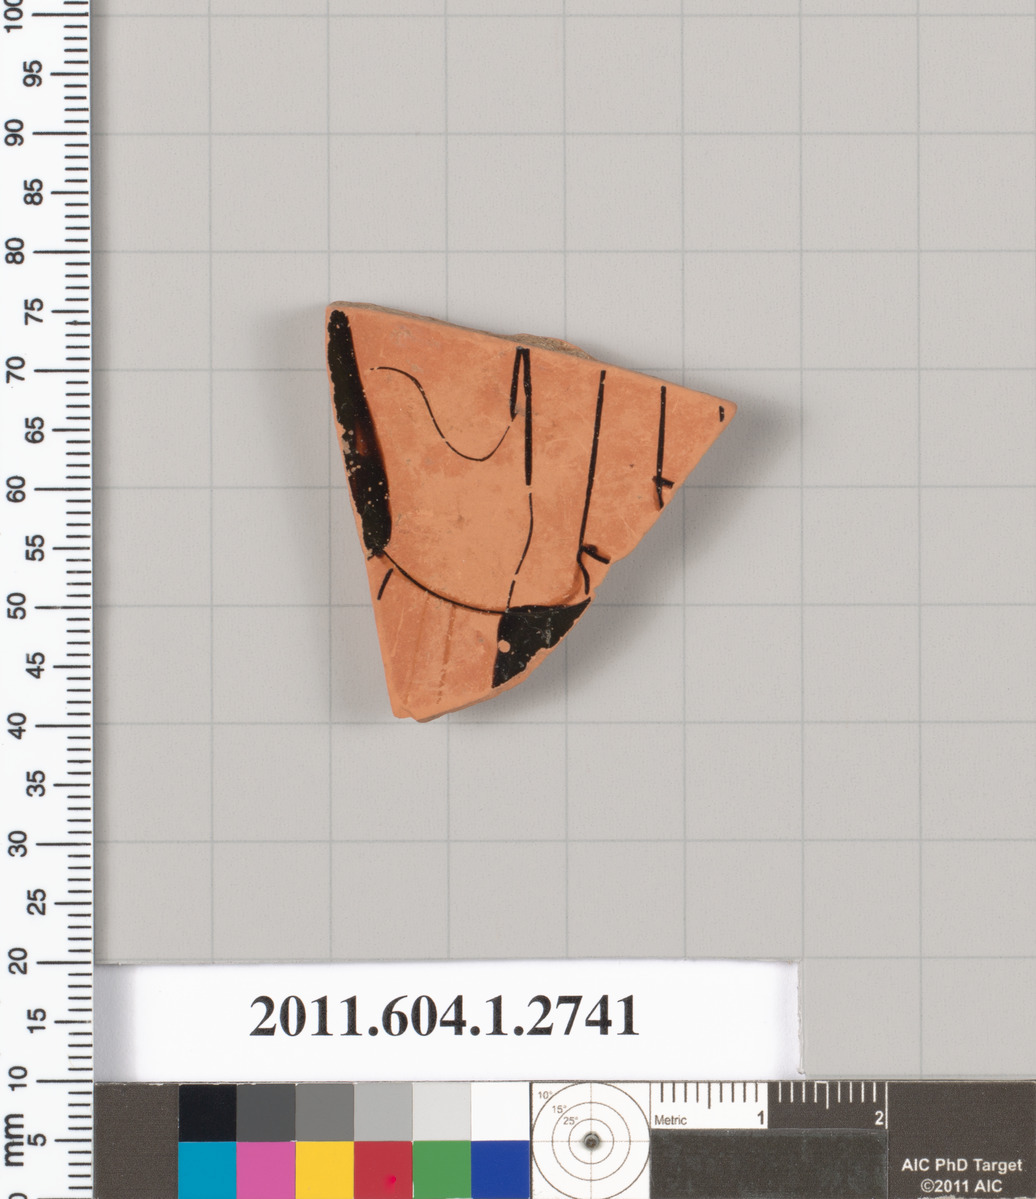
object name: kylix fragment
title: Terracotta fragment of a kylix (drinking cup)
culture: greek, attic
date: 467-435 BCE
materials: terracotta